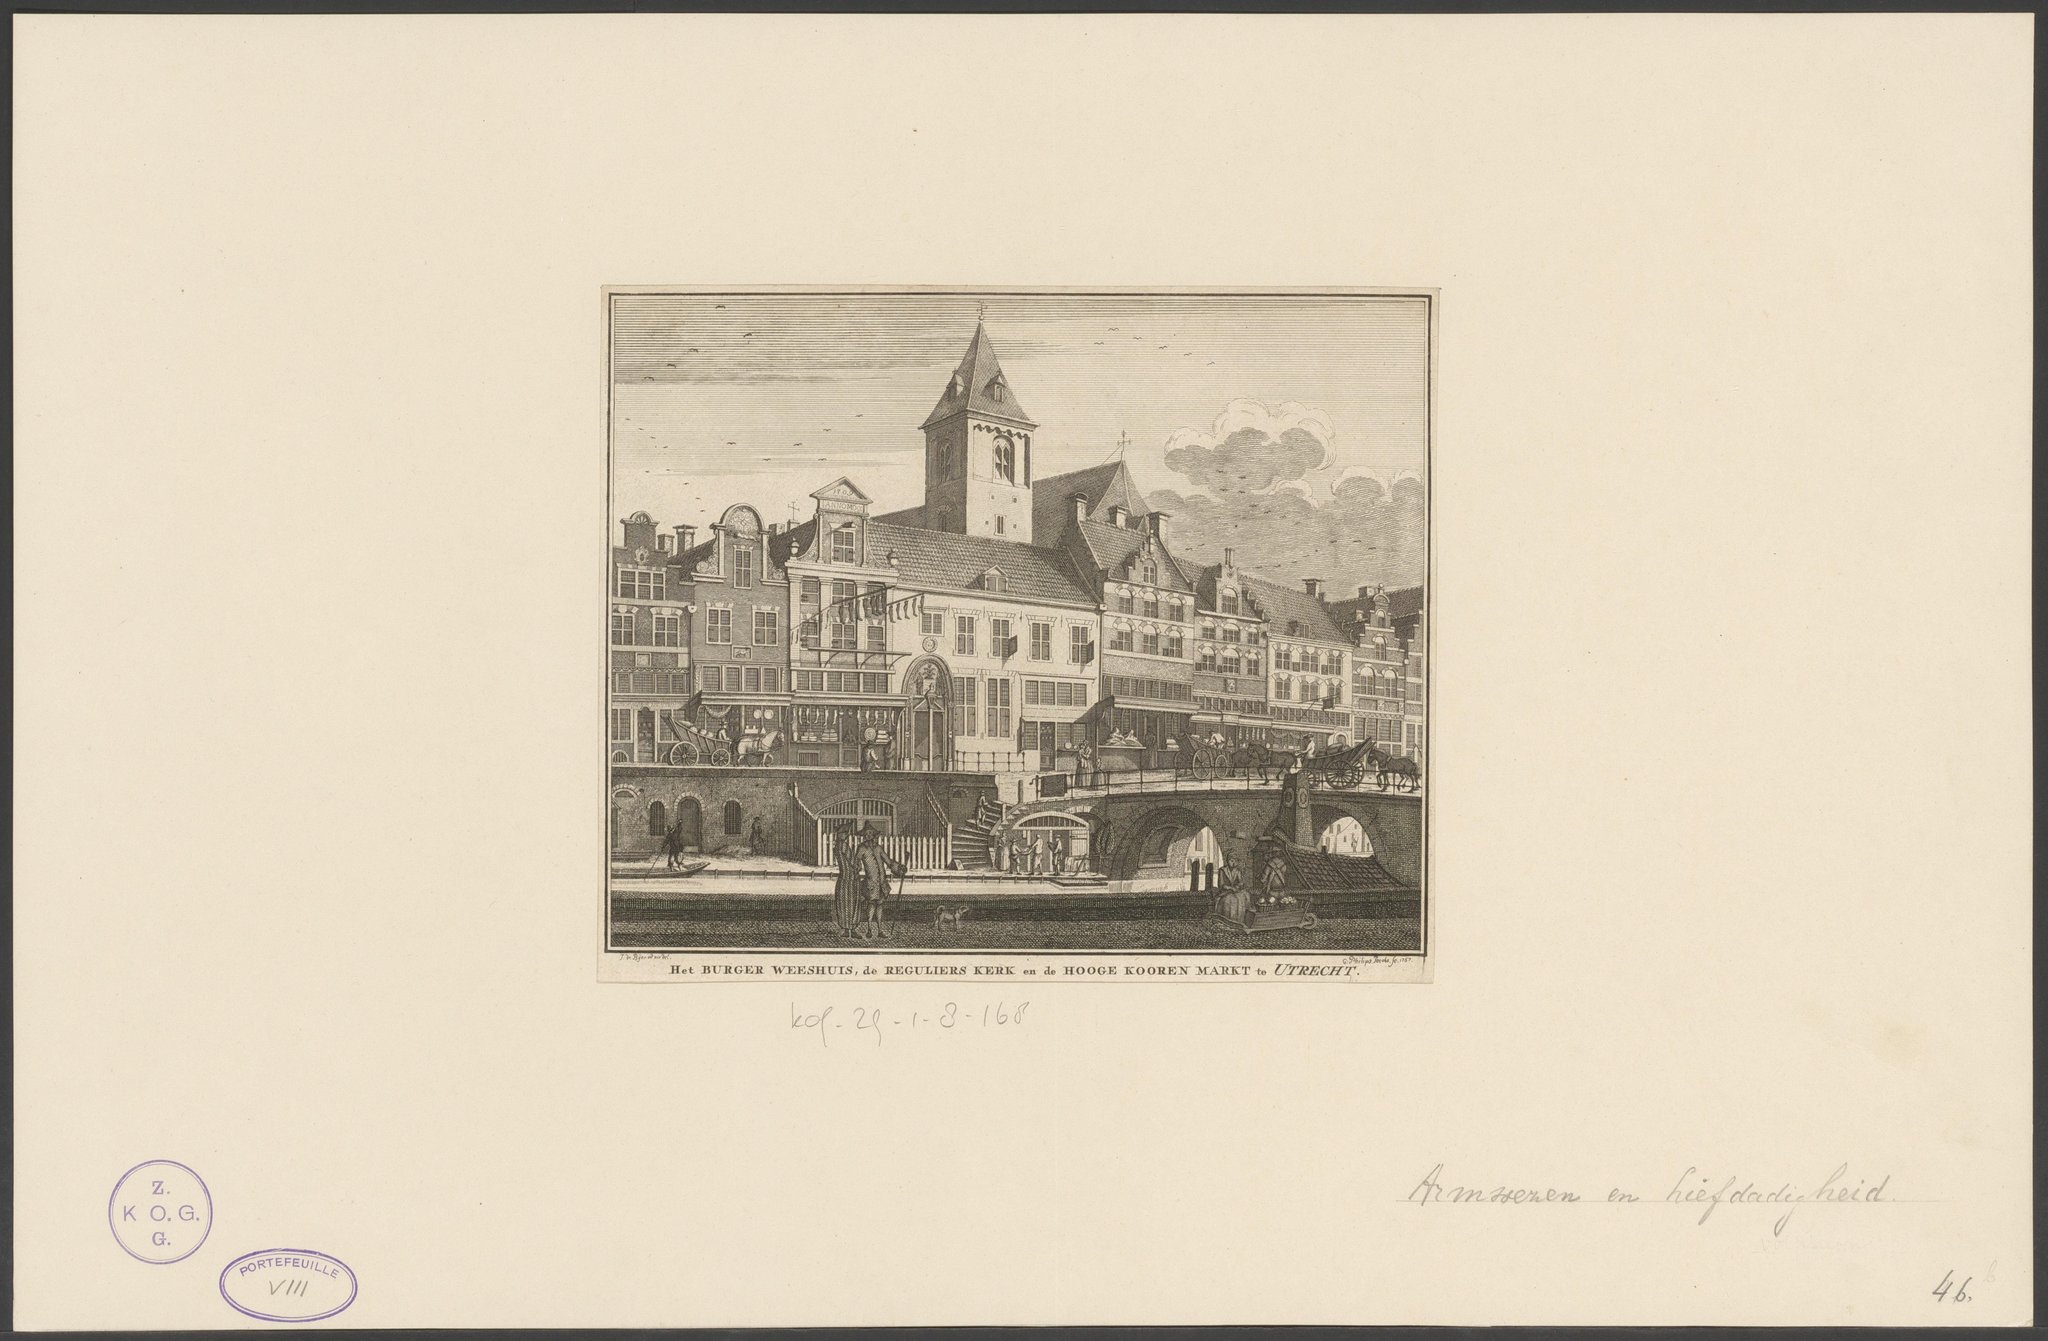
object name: print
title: Het Burger Weeshuis, de Reguliers Kerk en de Hooge Kooren Markt te Utrecht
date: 1757-1758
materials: paper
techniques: engraving, etching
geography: utrecht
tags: public welfare, city-view in general; 'veduta', church (exterior), orphanage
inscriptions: collector's mark: Lugt 1641, collector's mark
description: Prent ook gebruikt in: Tegenwoordige staat der Vereenigde Nederlanden, elfde deel, behelzende eene beschryving van de provincie van Utrecht. Met landkaarten, plans der steden en printverbeeldingen versierd / Hedendaagsche historie, of tegenwoordige staat van alle volkeren; XXI. deel (…). Amsterdam: Isaak Tirion, 1758, tussen p. 396 en p. 397.